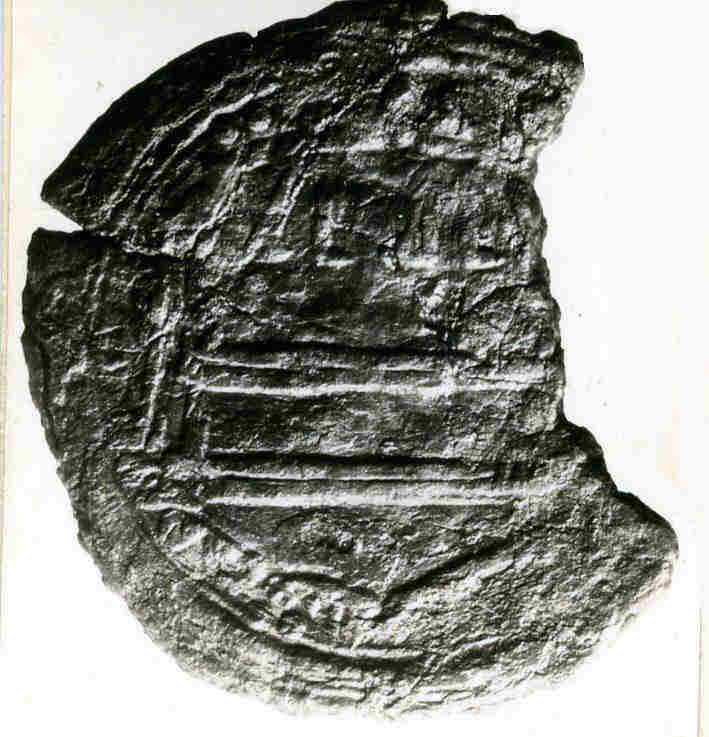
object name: coin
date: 701-800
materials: copper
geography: iran